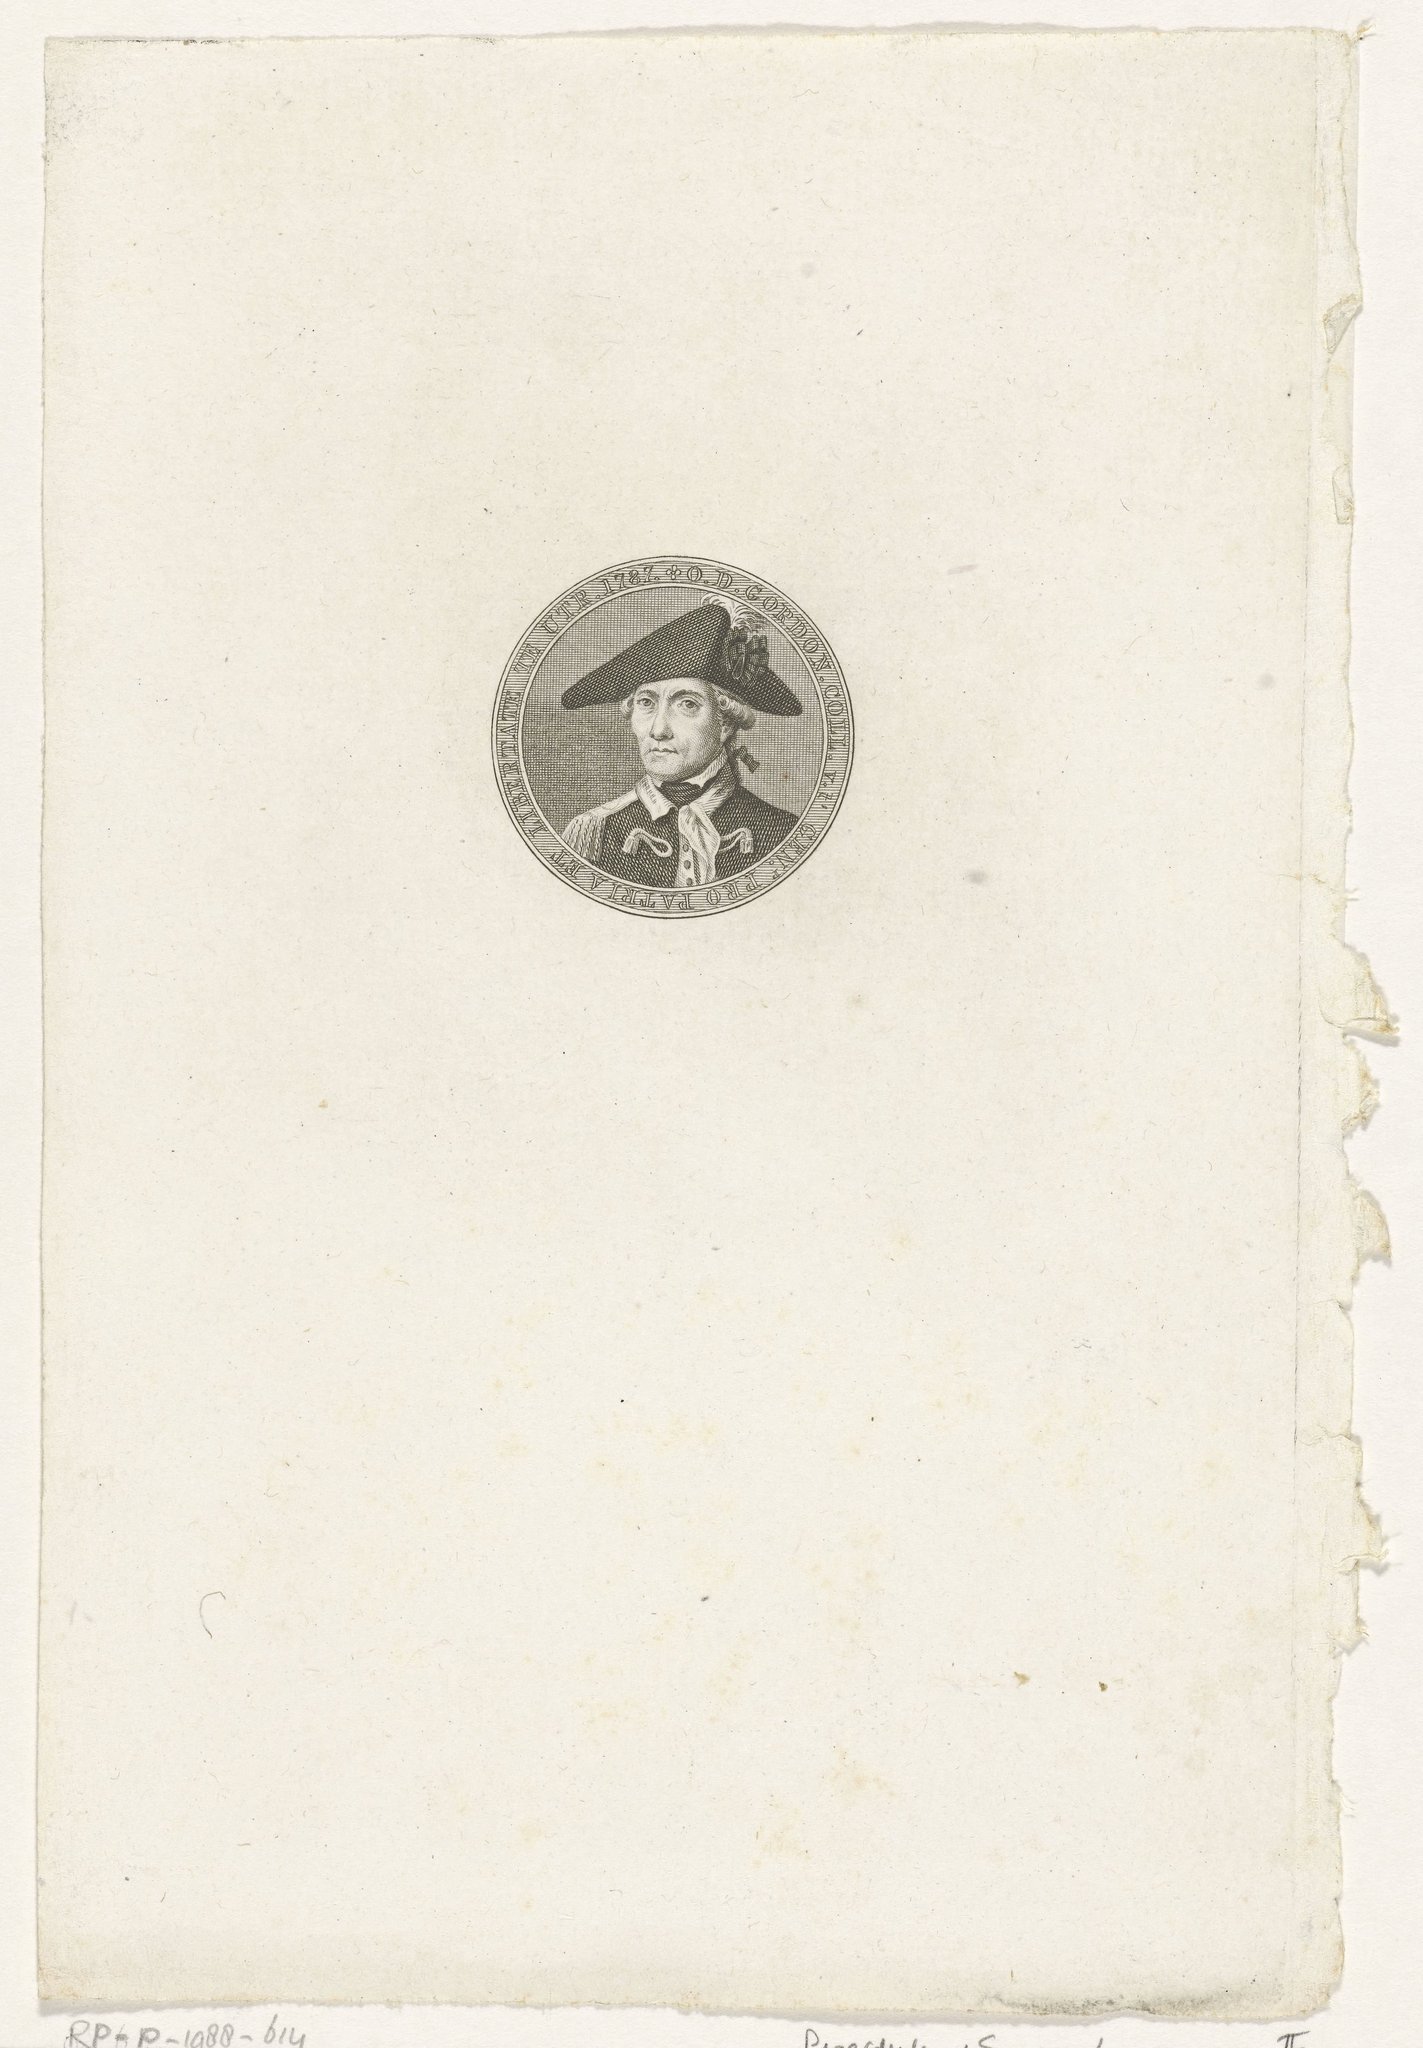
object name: print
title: Portret van Otto Dick Gordon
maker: abraham jacobsz. hulk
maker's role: print maker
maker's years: 1751-1817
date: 1787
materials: paper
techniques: engraving, etching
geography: paris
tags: otto derk gordon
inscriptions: collector's mark: Lugt 2228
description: Buste van Otto Dick Gordon, licht naar rechts, in een medaillon met randschrift in het Nederlands. Gordon draagt een steekhoed.